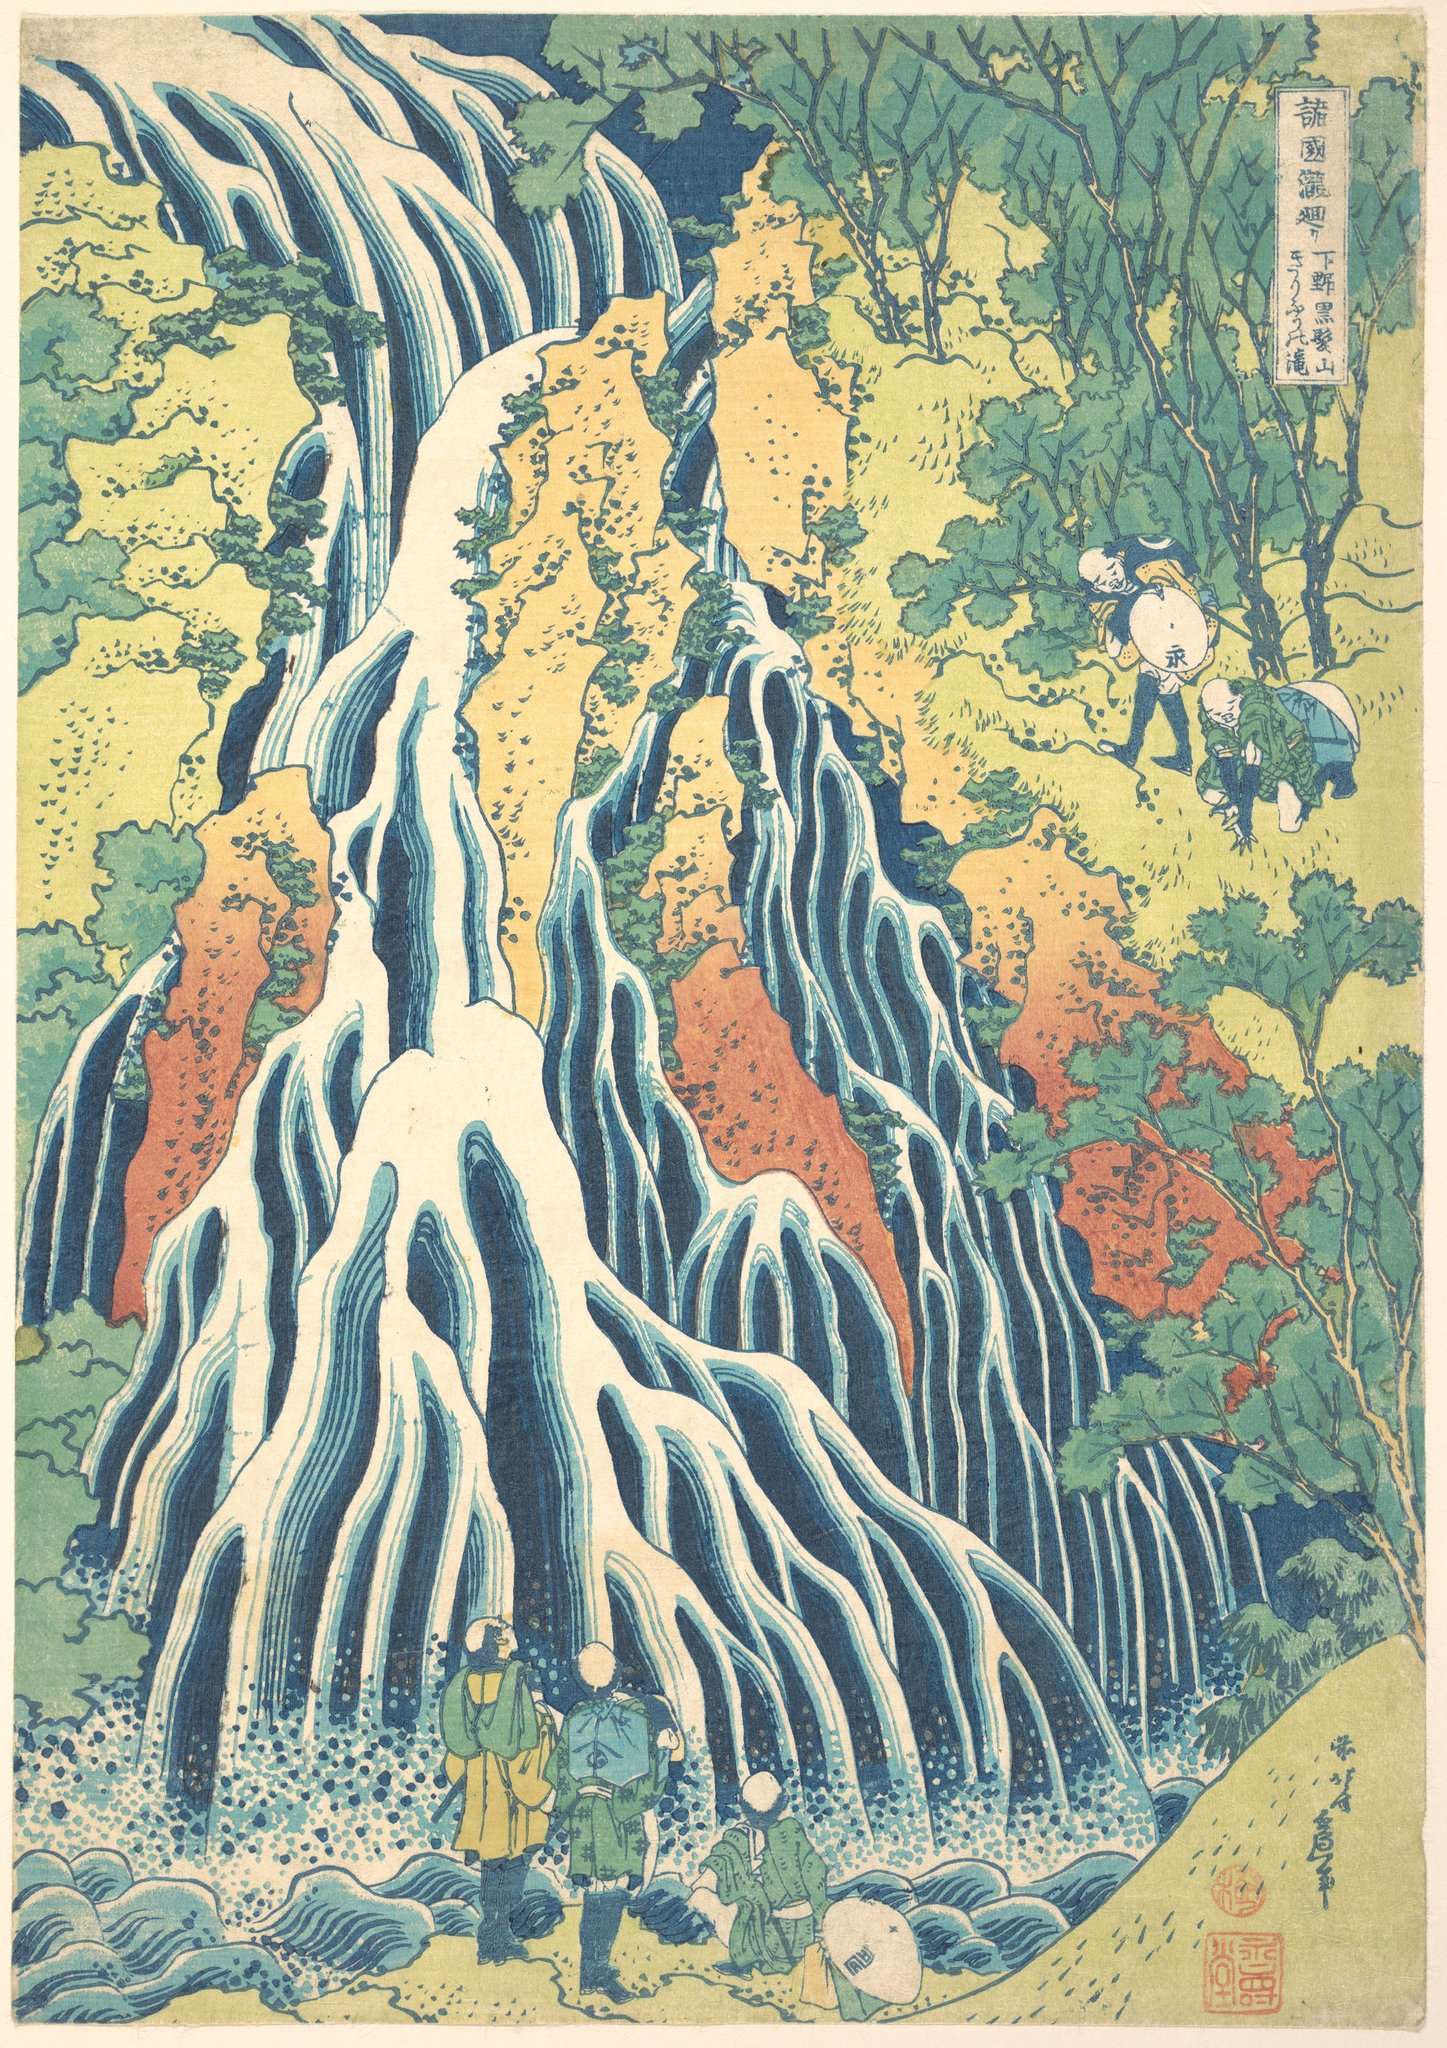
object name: woodblock print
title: Kirifuri Waterfall at Kurokami Mountain in Shimotsuke (Shimotsuke Kurokamiyama Kirifuri no taki), from the series A Tour of Waterfalls in Various Provinces (Shokoku taki meguri)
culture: japanese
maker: katsushika hokusai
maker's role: artist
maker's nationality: japanese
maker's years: 1760-1849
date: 1832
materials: ink, paper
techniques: woodblock print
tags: human figures,waterfalls,mountains,trees